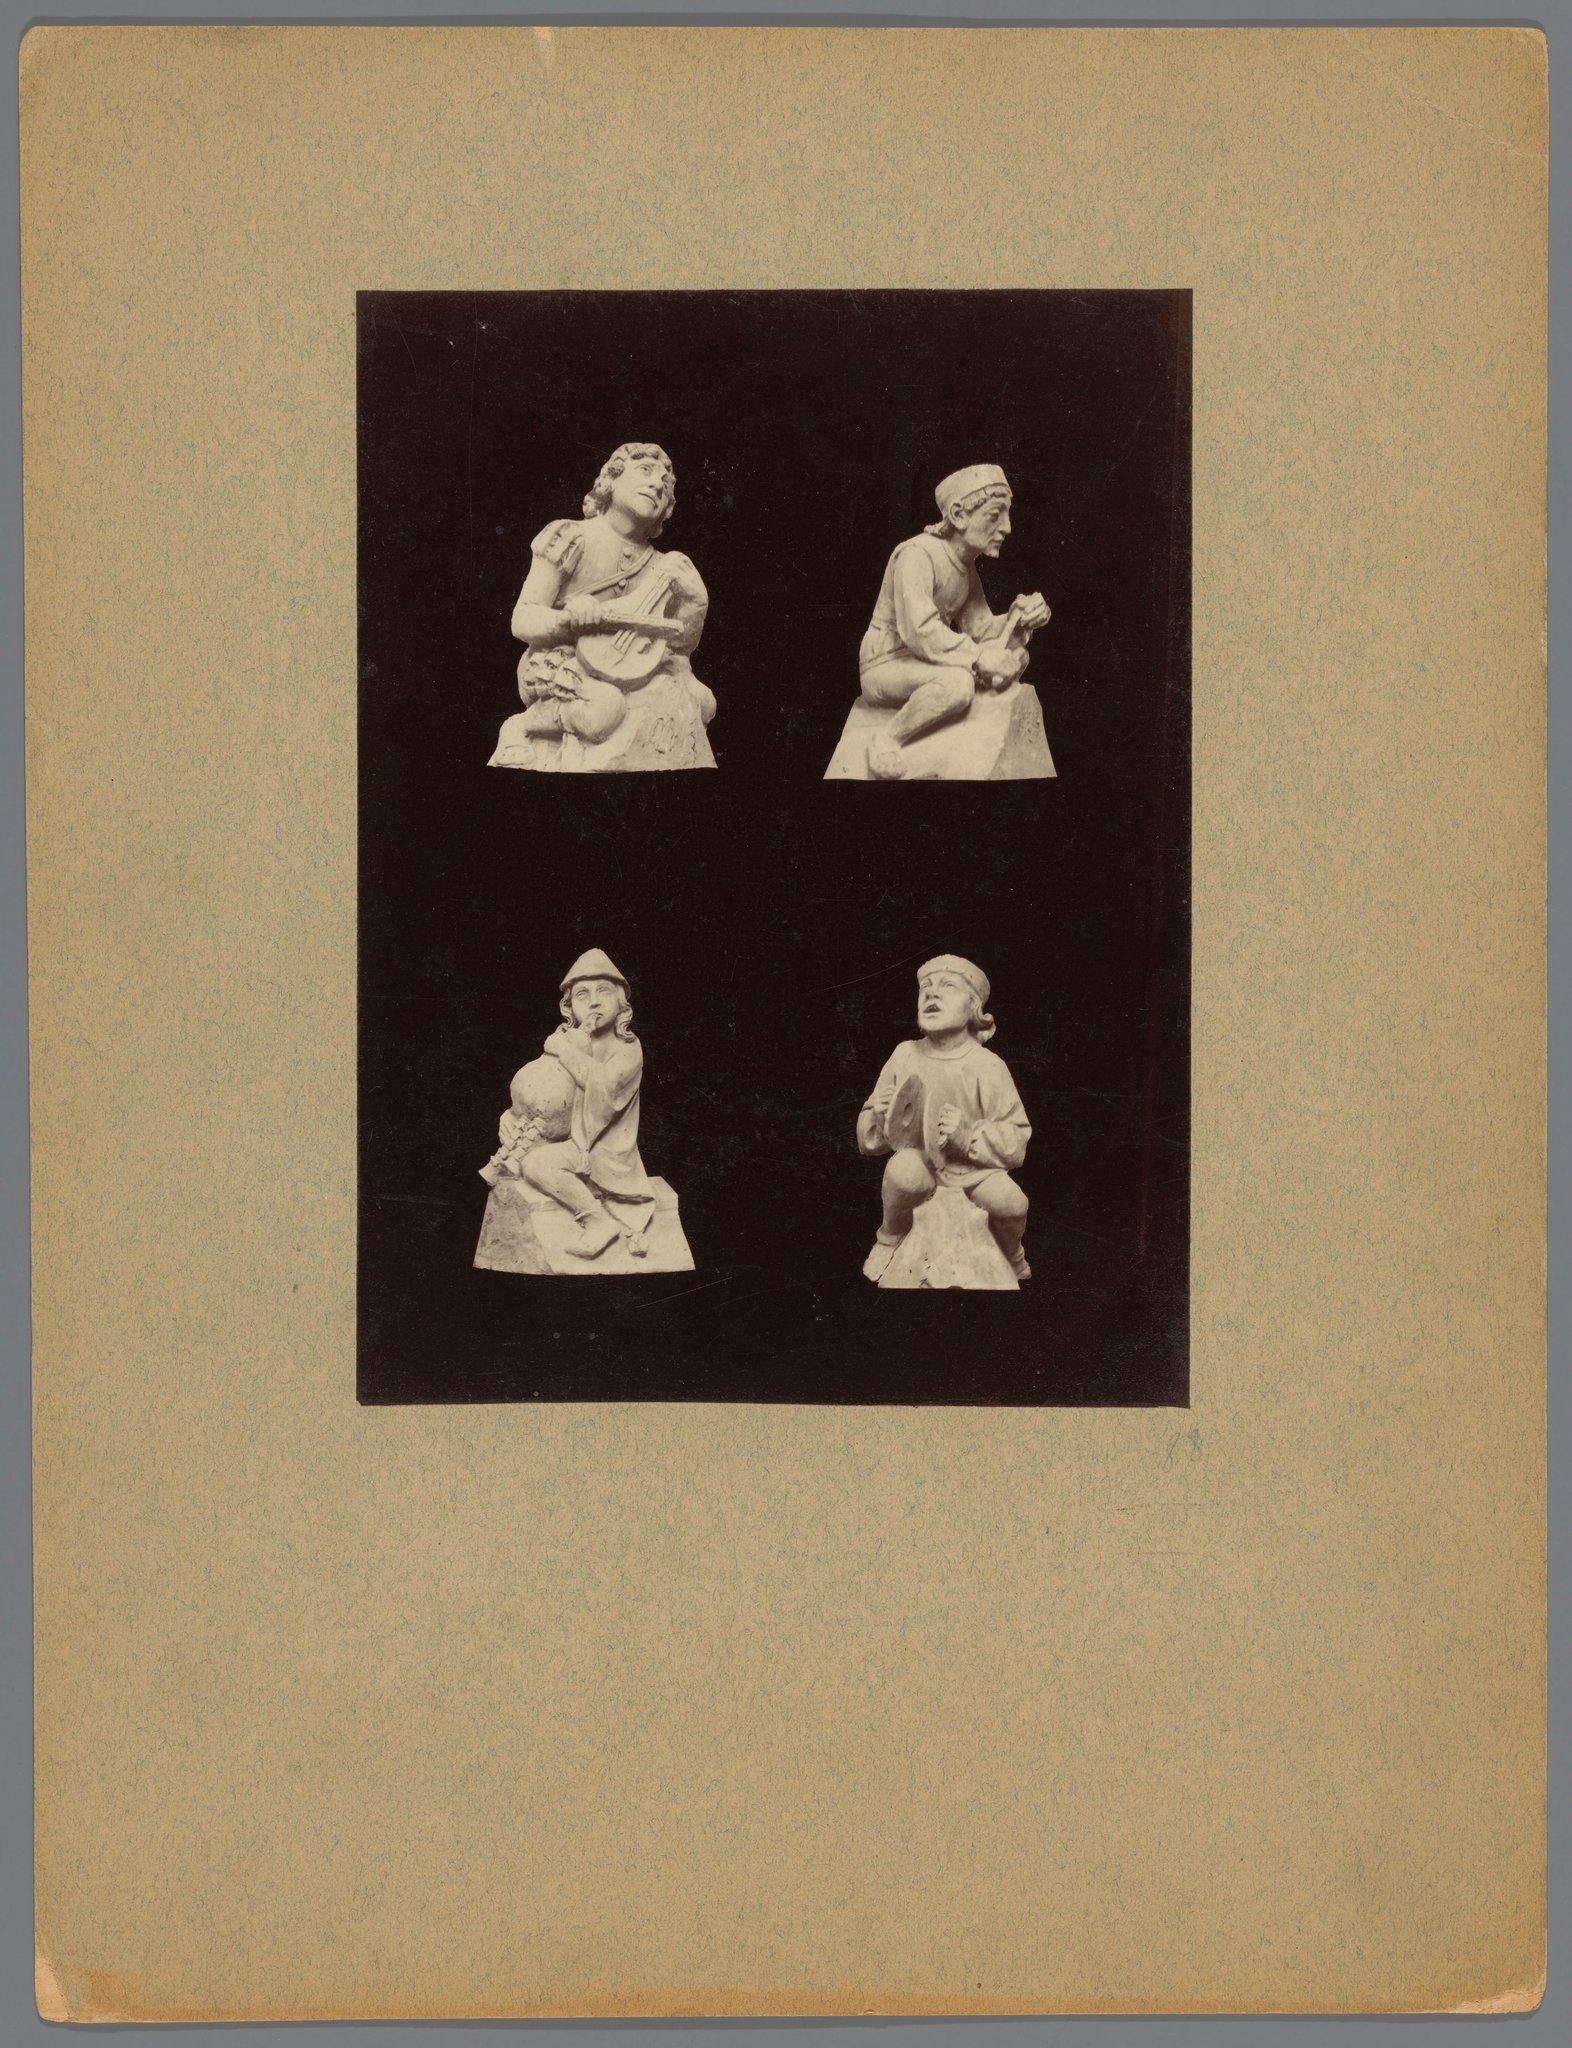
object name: photograph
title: Vier luchtboogfiguren van de Sint-Janskathedraal te 's-Hertogenbosch in de vorm van muzikanten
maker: Anonymous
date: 1875-1900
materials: cardboard, photographic support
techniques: albumen print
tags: musician at work, bagpipe, musette, sculpture, string instruments (bowed)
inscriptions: collector's mark: Lugt 3937, name: ‘Kunstboekhandel J. A. G. de Leur photograaf-uitgever Huigenspark 40b. Den Haag.’